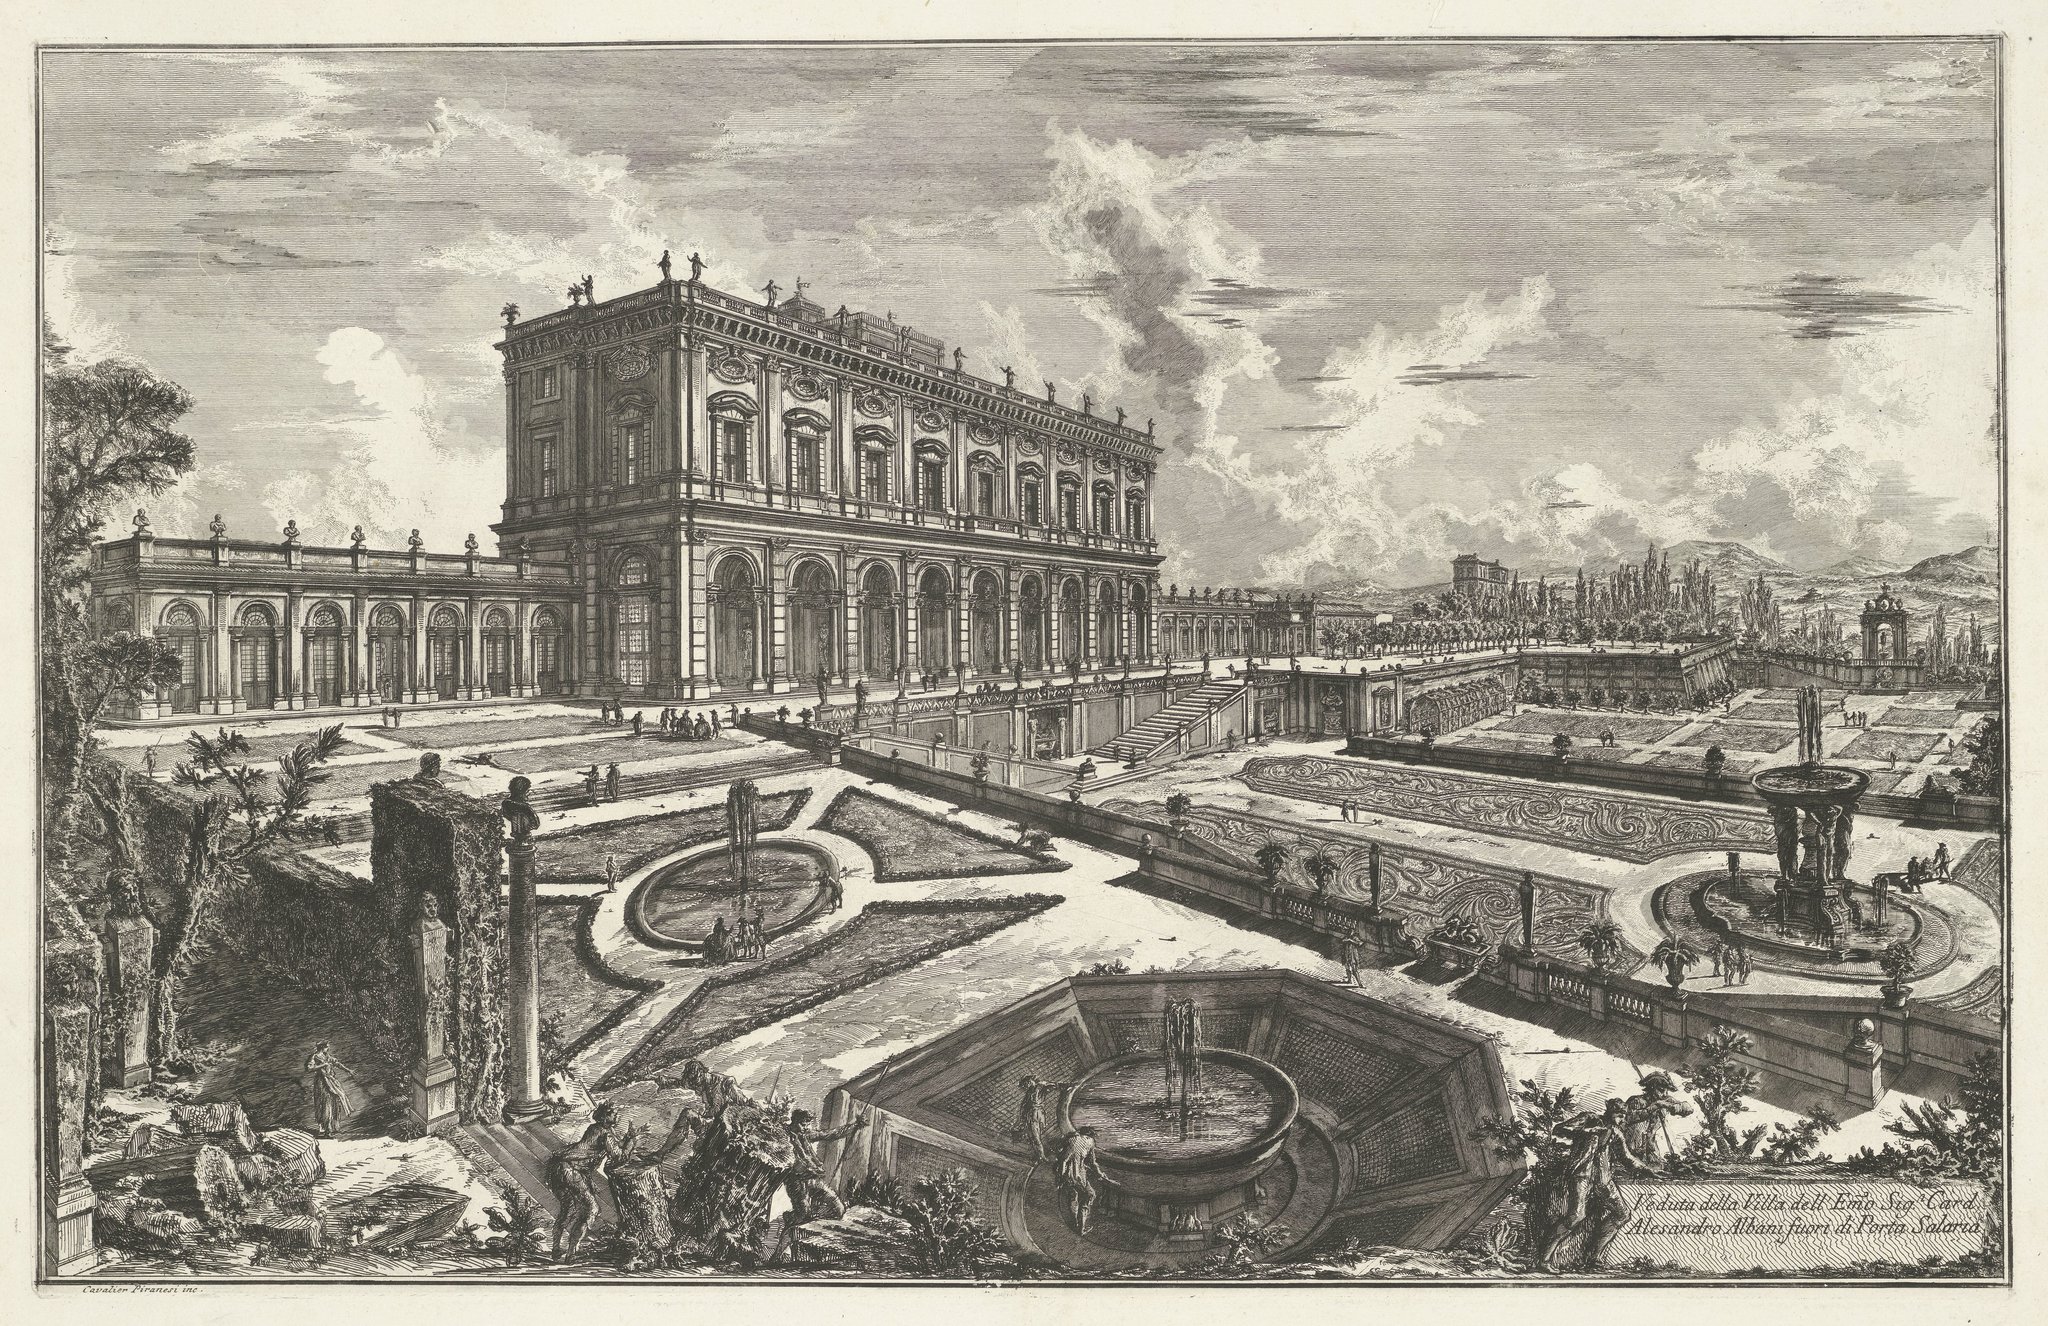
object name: print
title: Gezichten op Rome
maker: giovanni battista piranesi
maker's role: designer, draughtsman, print maker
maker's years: 1720-1778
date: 1748-1778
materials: paper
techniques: etching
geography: rome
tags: garden, garden fountain, garden ornaments, villa, rome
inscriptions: collector's mark: Lugt 2228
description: Deze prent maakt deel uit van de serie 'Vedute di Roma'. Piranesi werkte aan deze 135 platen tellende serie tussen 1748 en zijn dood in 1778. Francesco Piranesi voegde later nog twee prenten toe aan de reeks van zijn vader.